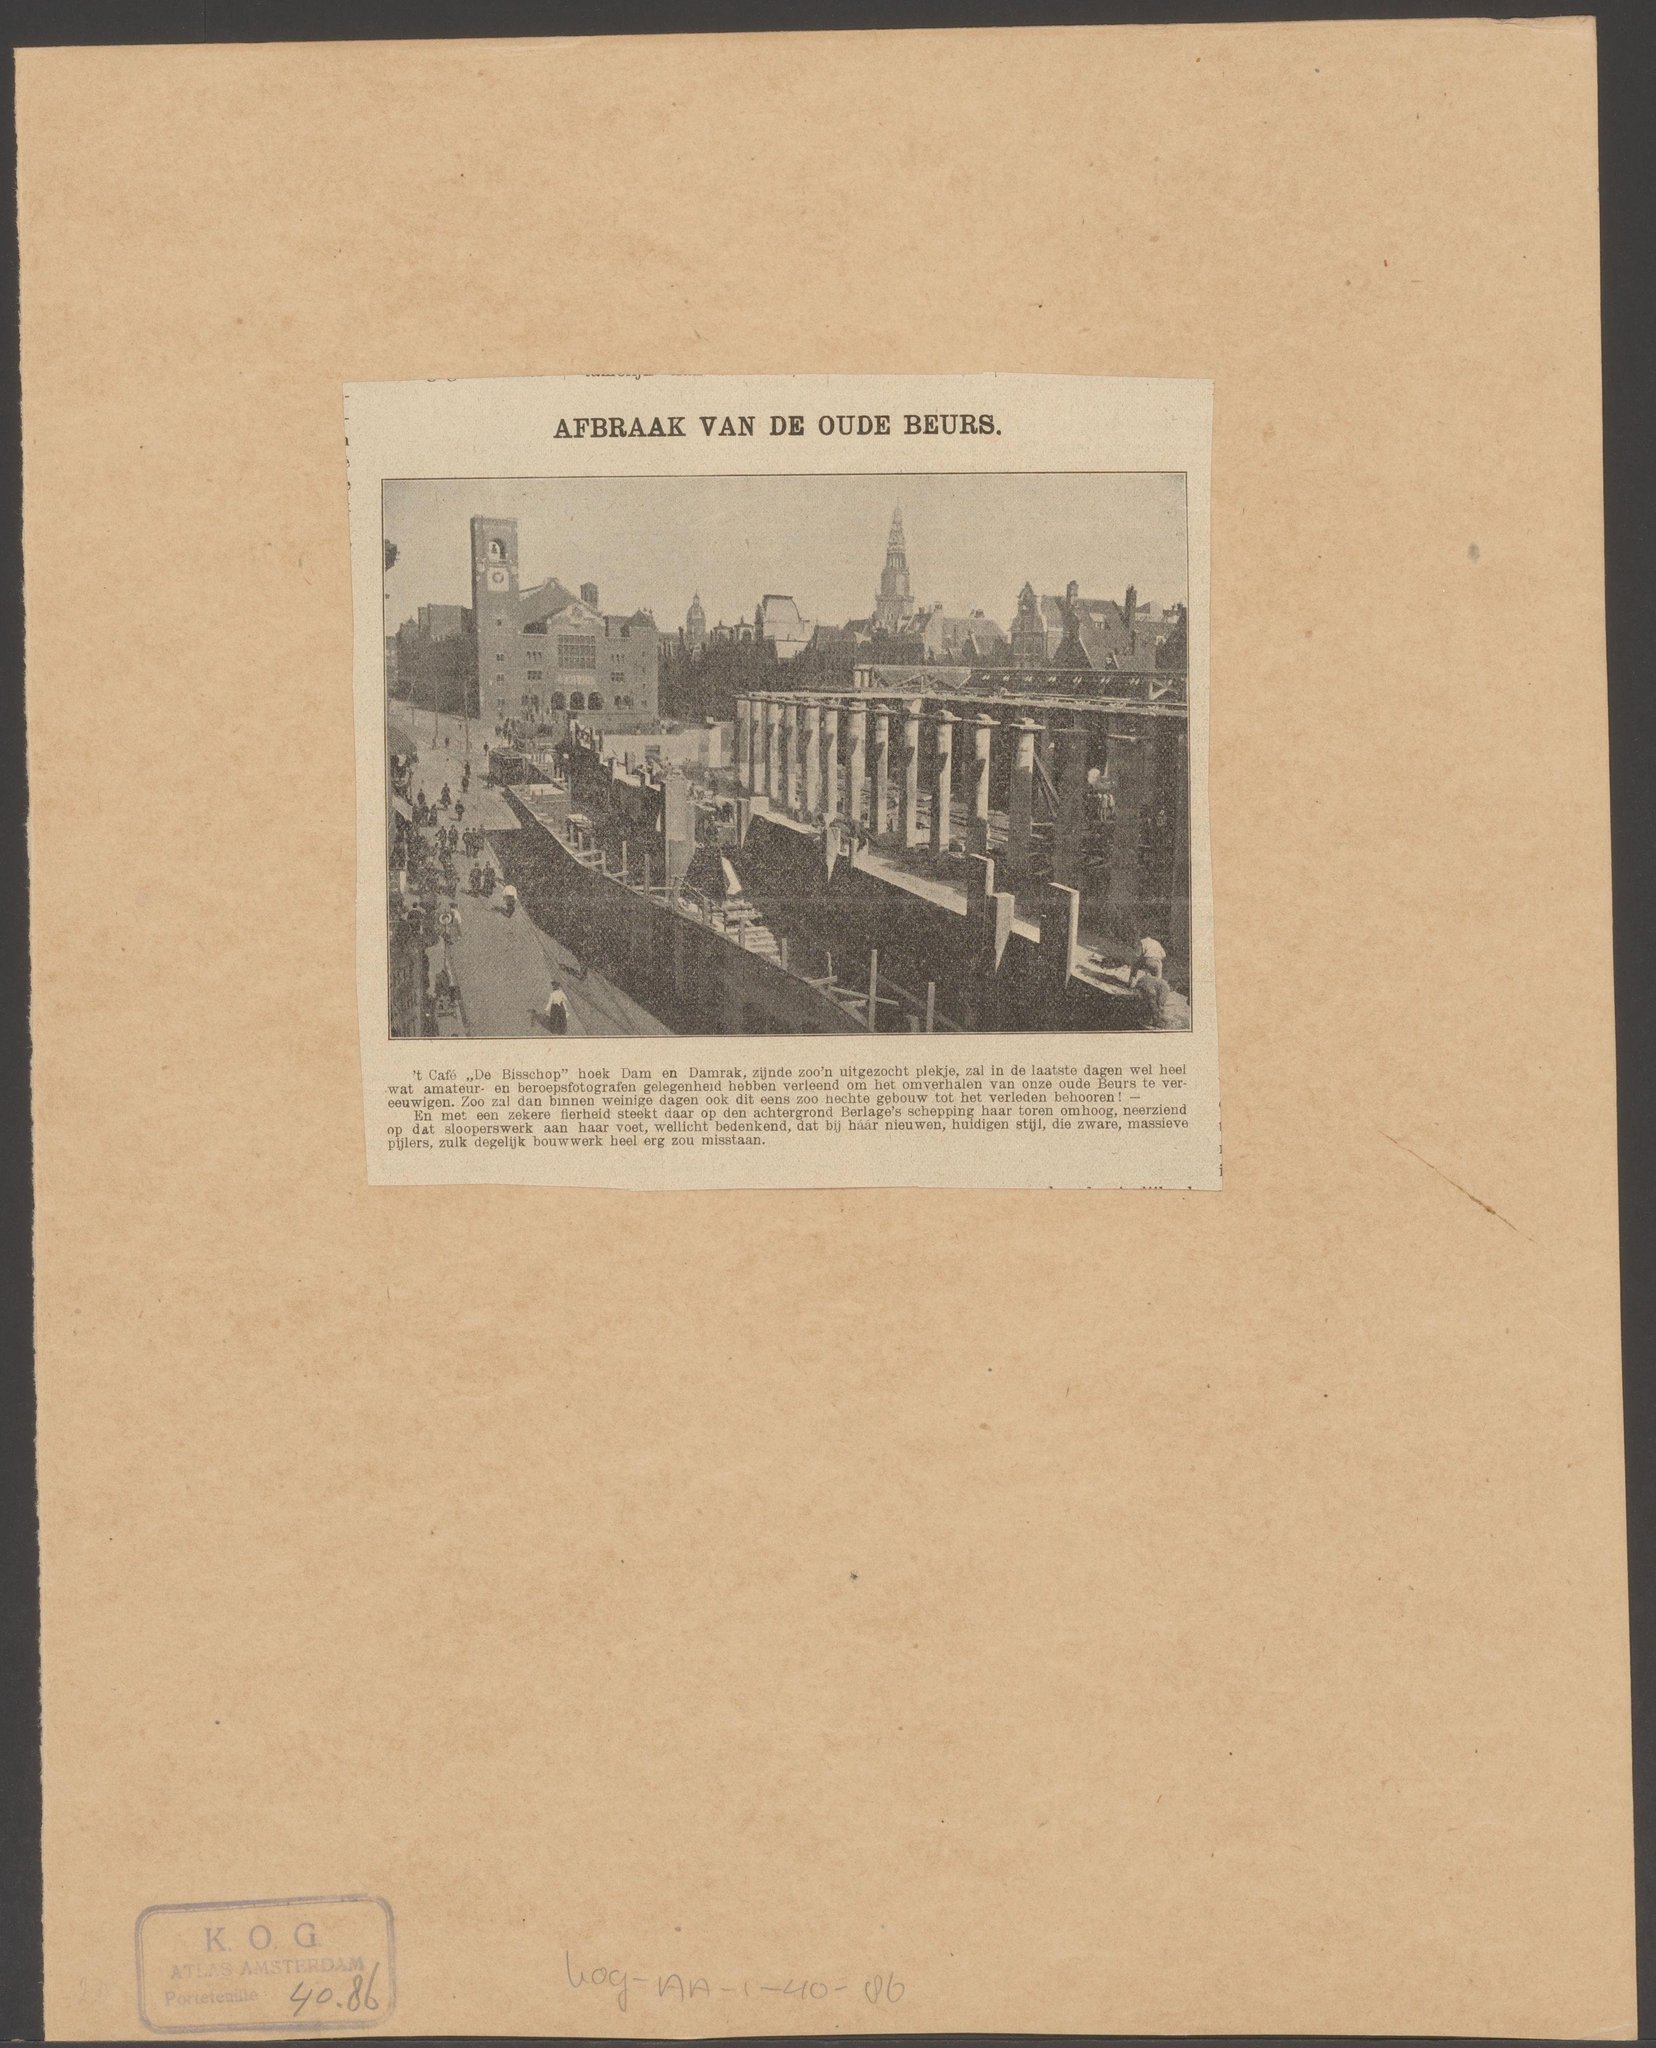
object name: photomechanical print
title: Afbraak van de Oude Beurs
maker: Anonymous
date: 1903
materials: paper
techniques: letterpress printing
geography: netherlands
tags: stock exchange, stock-market, demolition of building, street (+ city(-scape) with figures, staffage)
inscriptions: collector's mark: Lugt 1641b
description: Onderwerpsrubriek binnen de Atlas Amsterdam: Handel en Zeevaart: Hulpbeurs op de Dam en Beurs (Dam).